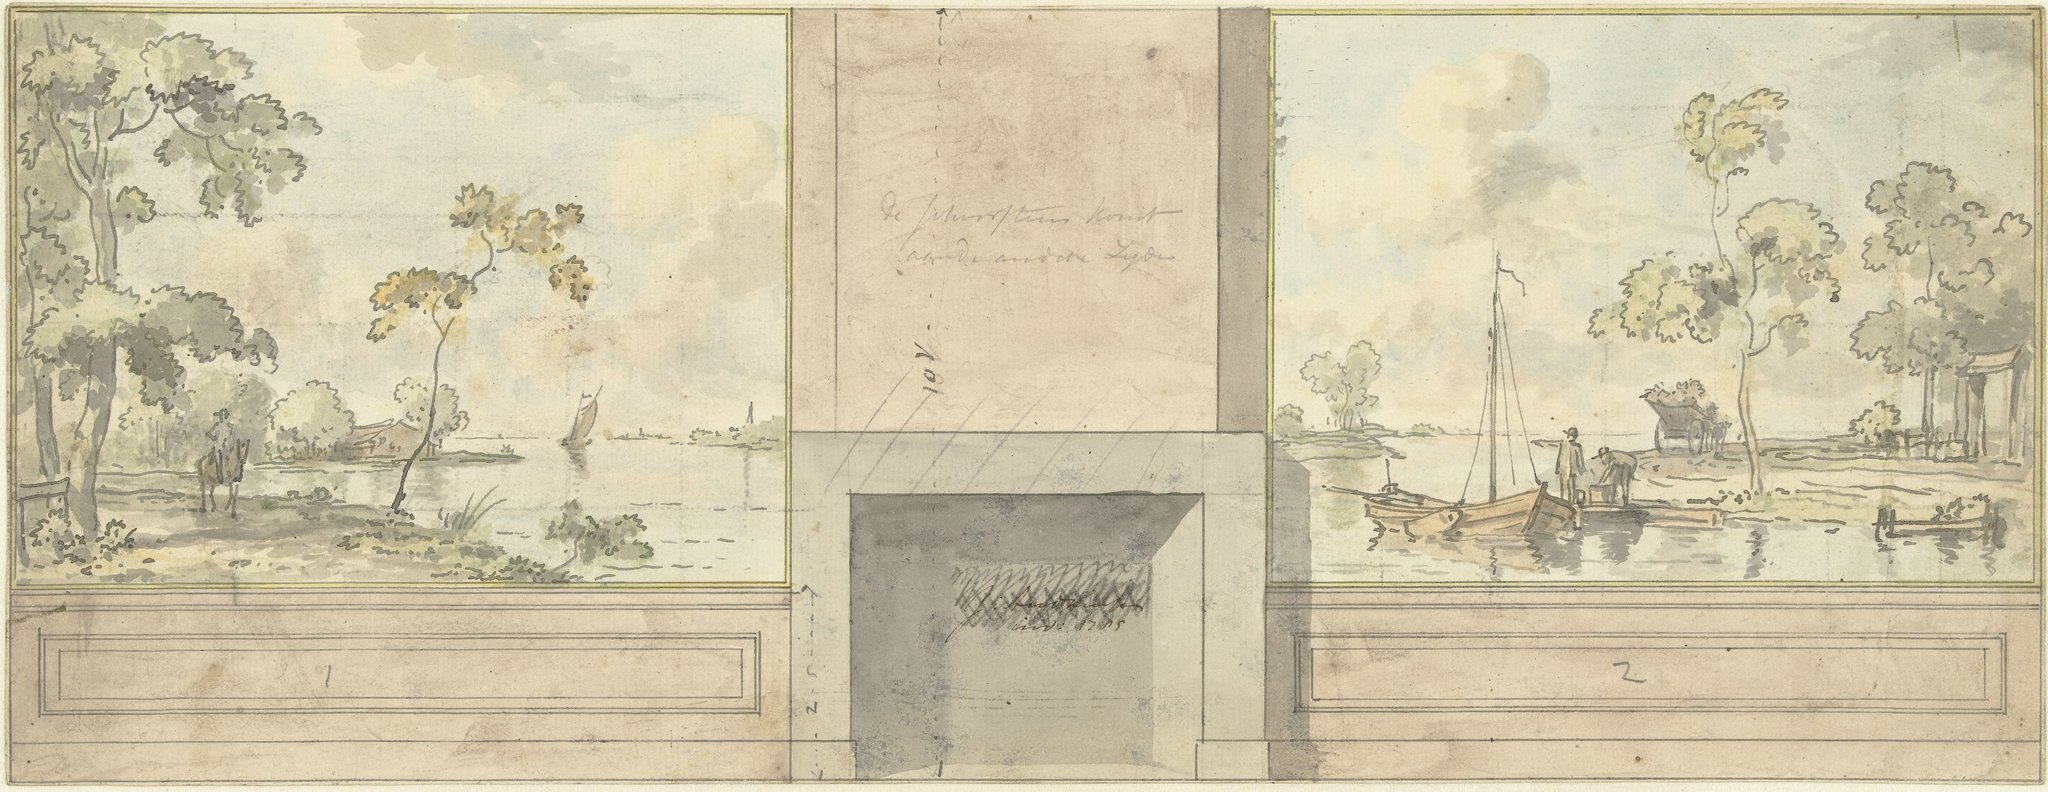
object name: drawing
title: Ontwerp voor kamerwand voor de eetkamer van D. Luden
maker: jurriaan andriessen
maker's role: draughtsman, painter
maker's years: 1742-1819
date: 1785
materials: graphite, ink, paper, watercolor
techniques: brush, pen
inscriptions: date: ‘1785’